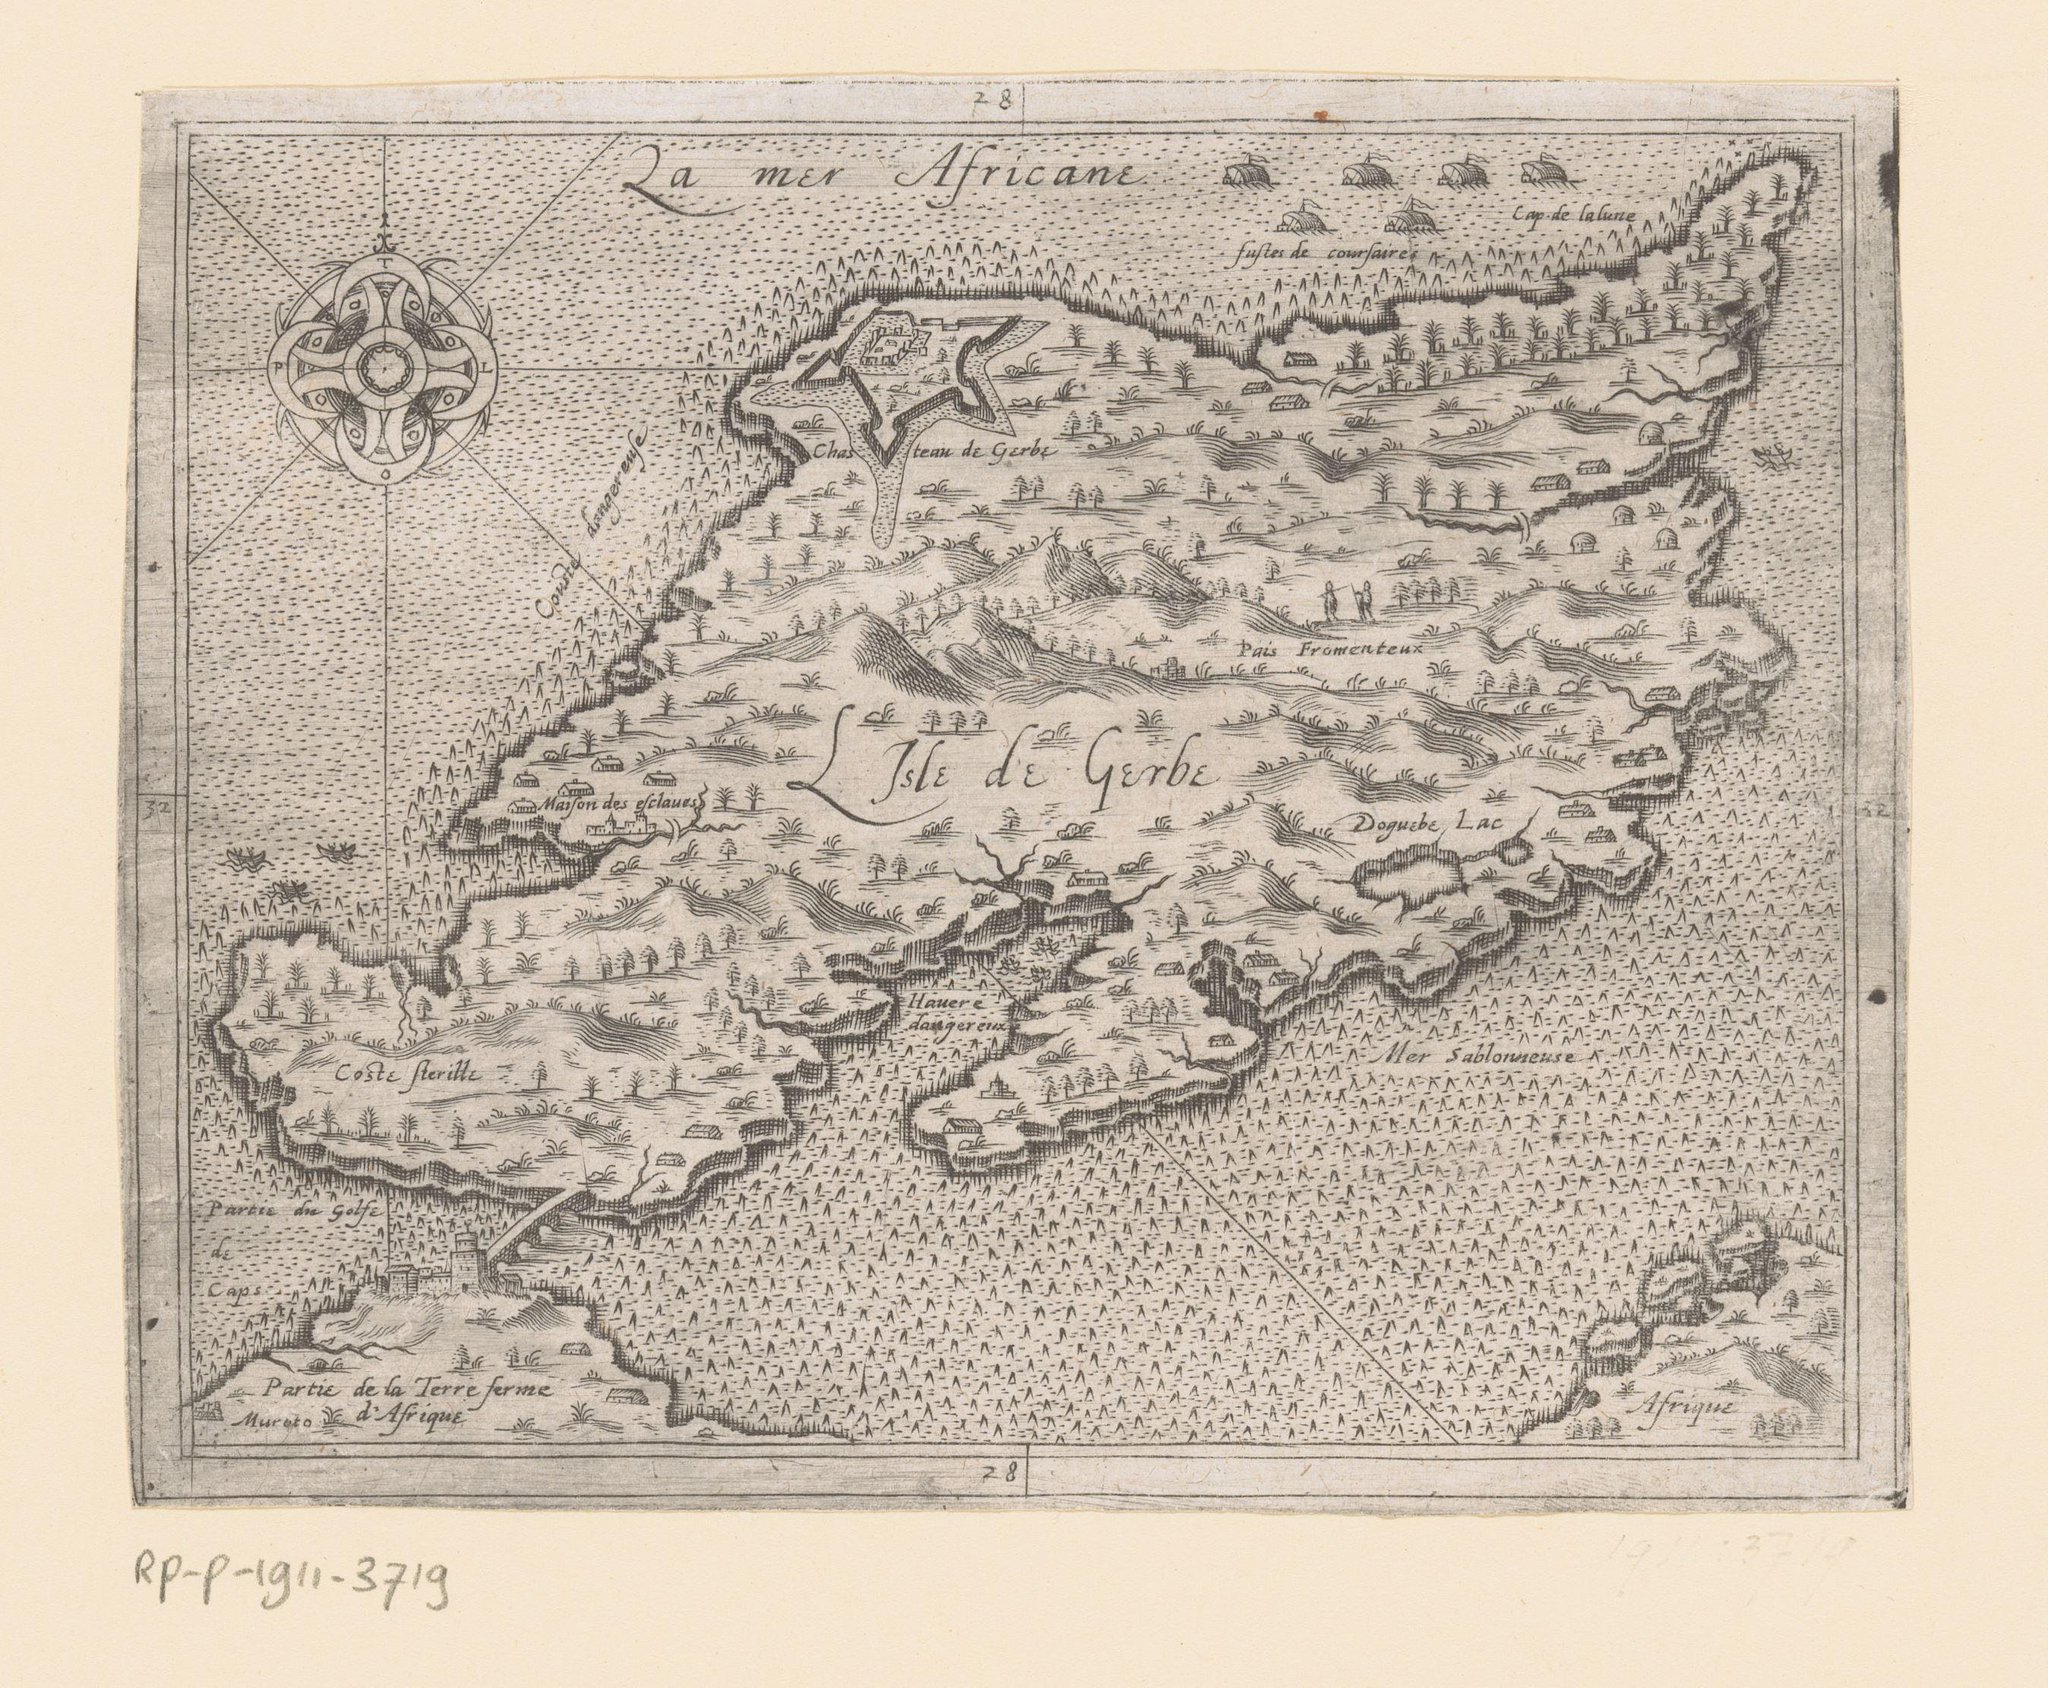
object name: print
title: Kaart van het eiland Djerba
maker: Anonymous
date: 1600-1700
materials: paper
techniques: etching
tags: island, maps, atlases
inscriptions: collector's mark: Lugt 2228